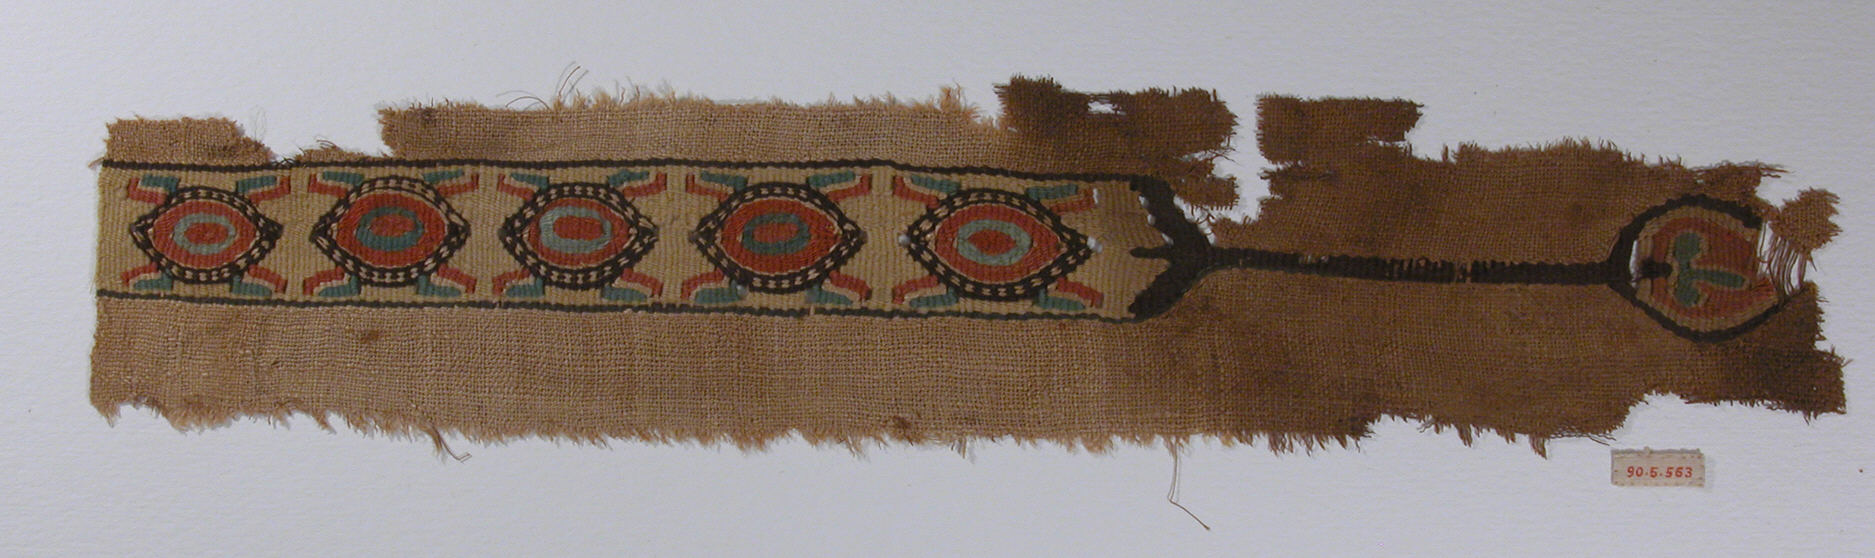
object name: textile fragment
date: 401-600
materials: linen, wool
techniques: weave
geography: egypt